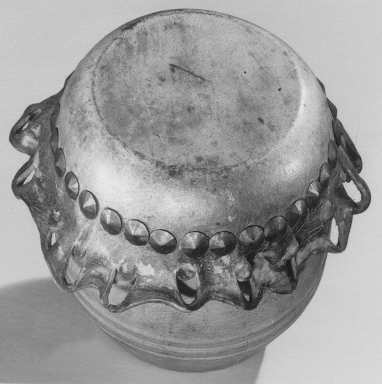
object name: gu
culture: chinese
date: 1801-1900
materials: wood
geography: china